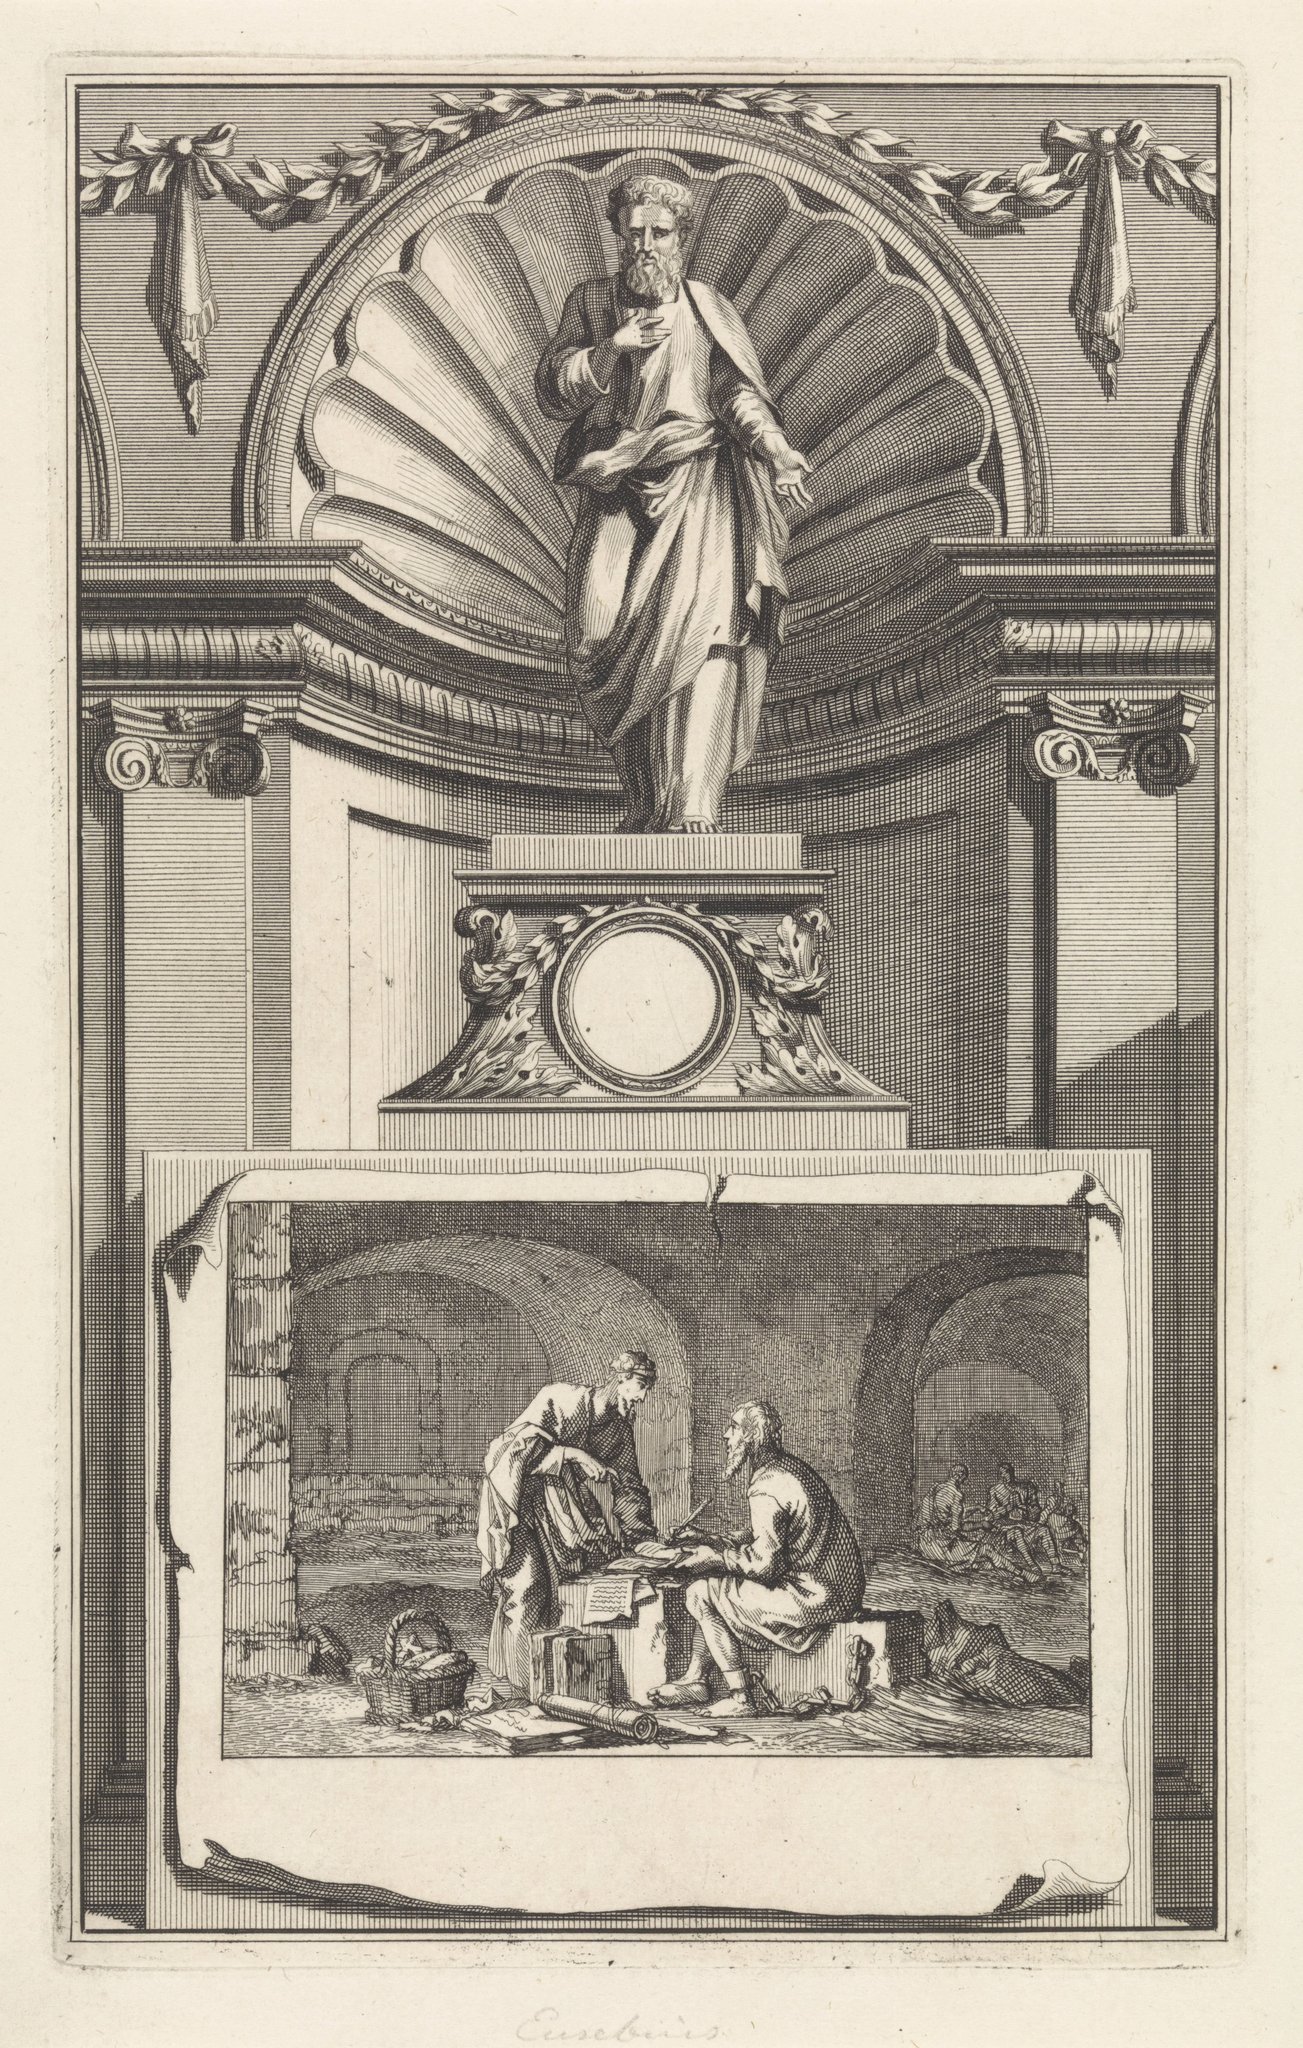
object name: print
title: Kerkvader Eusebius van Caesarea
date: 1698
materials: paper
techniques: engraving, etching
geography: amsterdam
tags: prison, jail, male saints (eusebius of caesarea), male saints (with name)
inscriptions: collector's mark: Lugt 2228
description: Proefdruk van illustratie uit: Cave, William. Apostolische oudheden, of Het leven (...) der heylige apostelen, 3 delen. Utrecht: François Halma en Willem van de Water (I), 1698, p. 79.